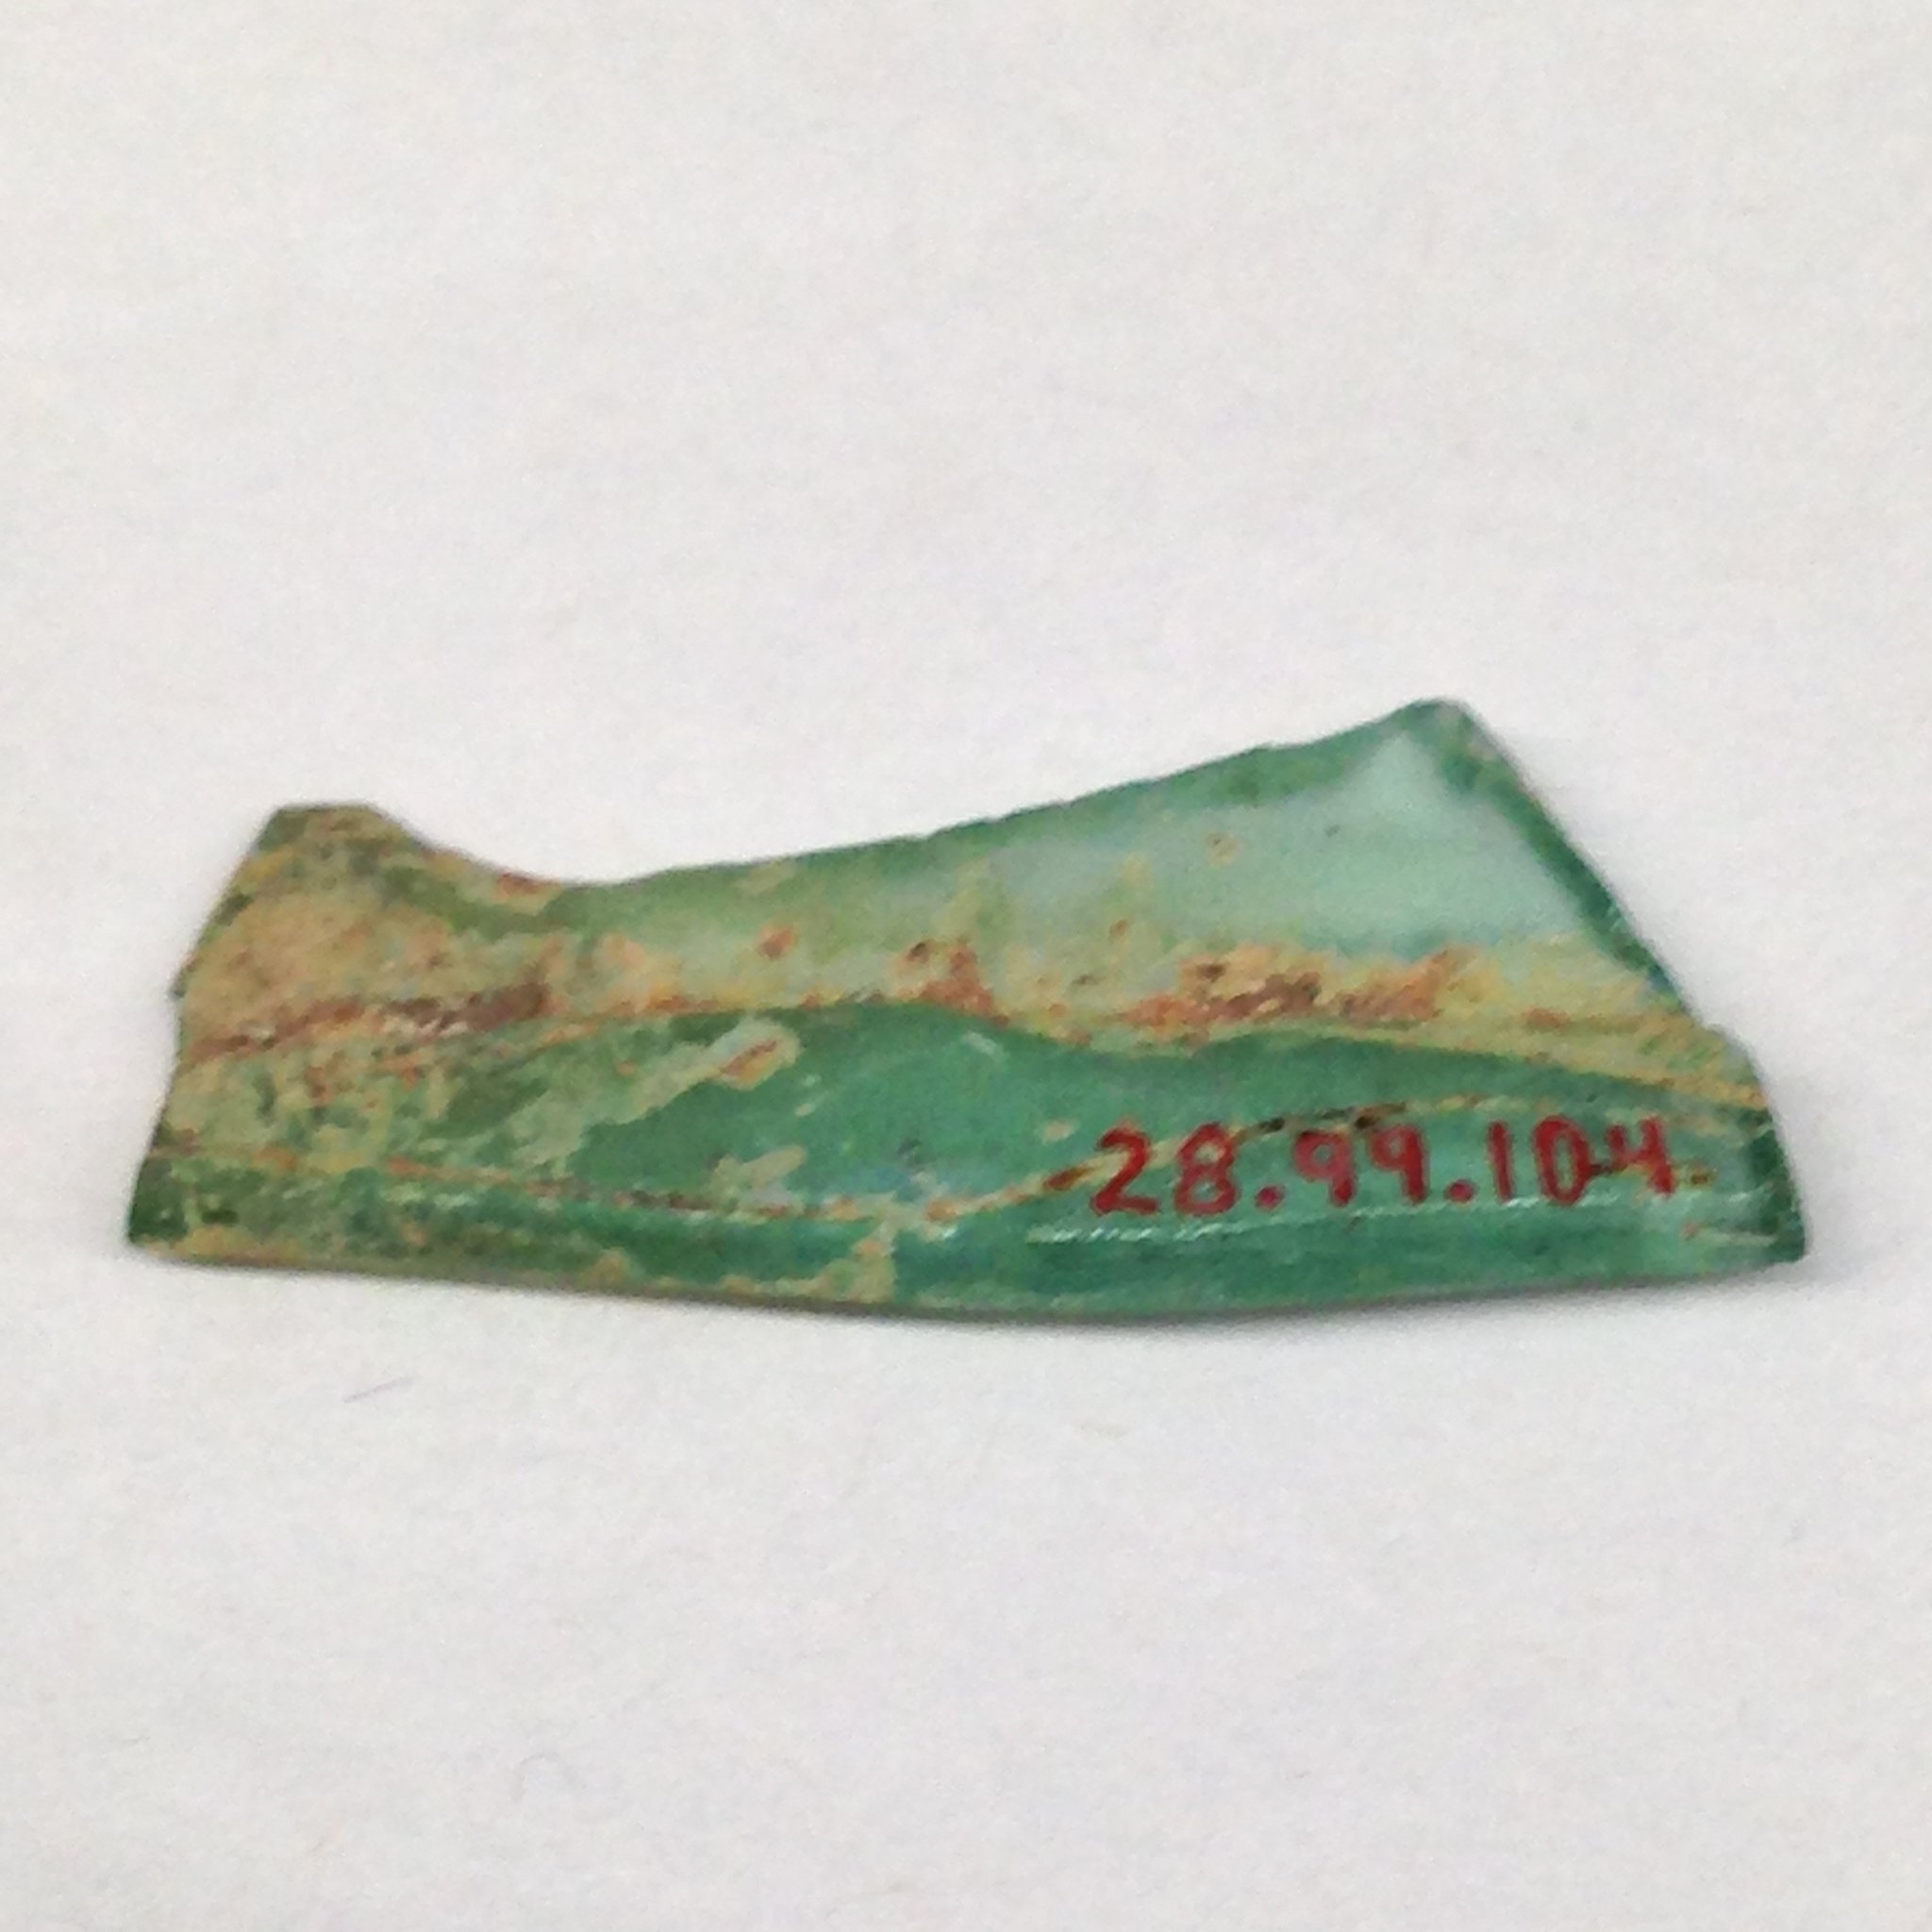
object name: fragment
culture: european or middle eastern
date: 1150-1250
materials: ceramic, glass